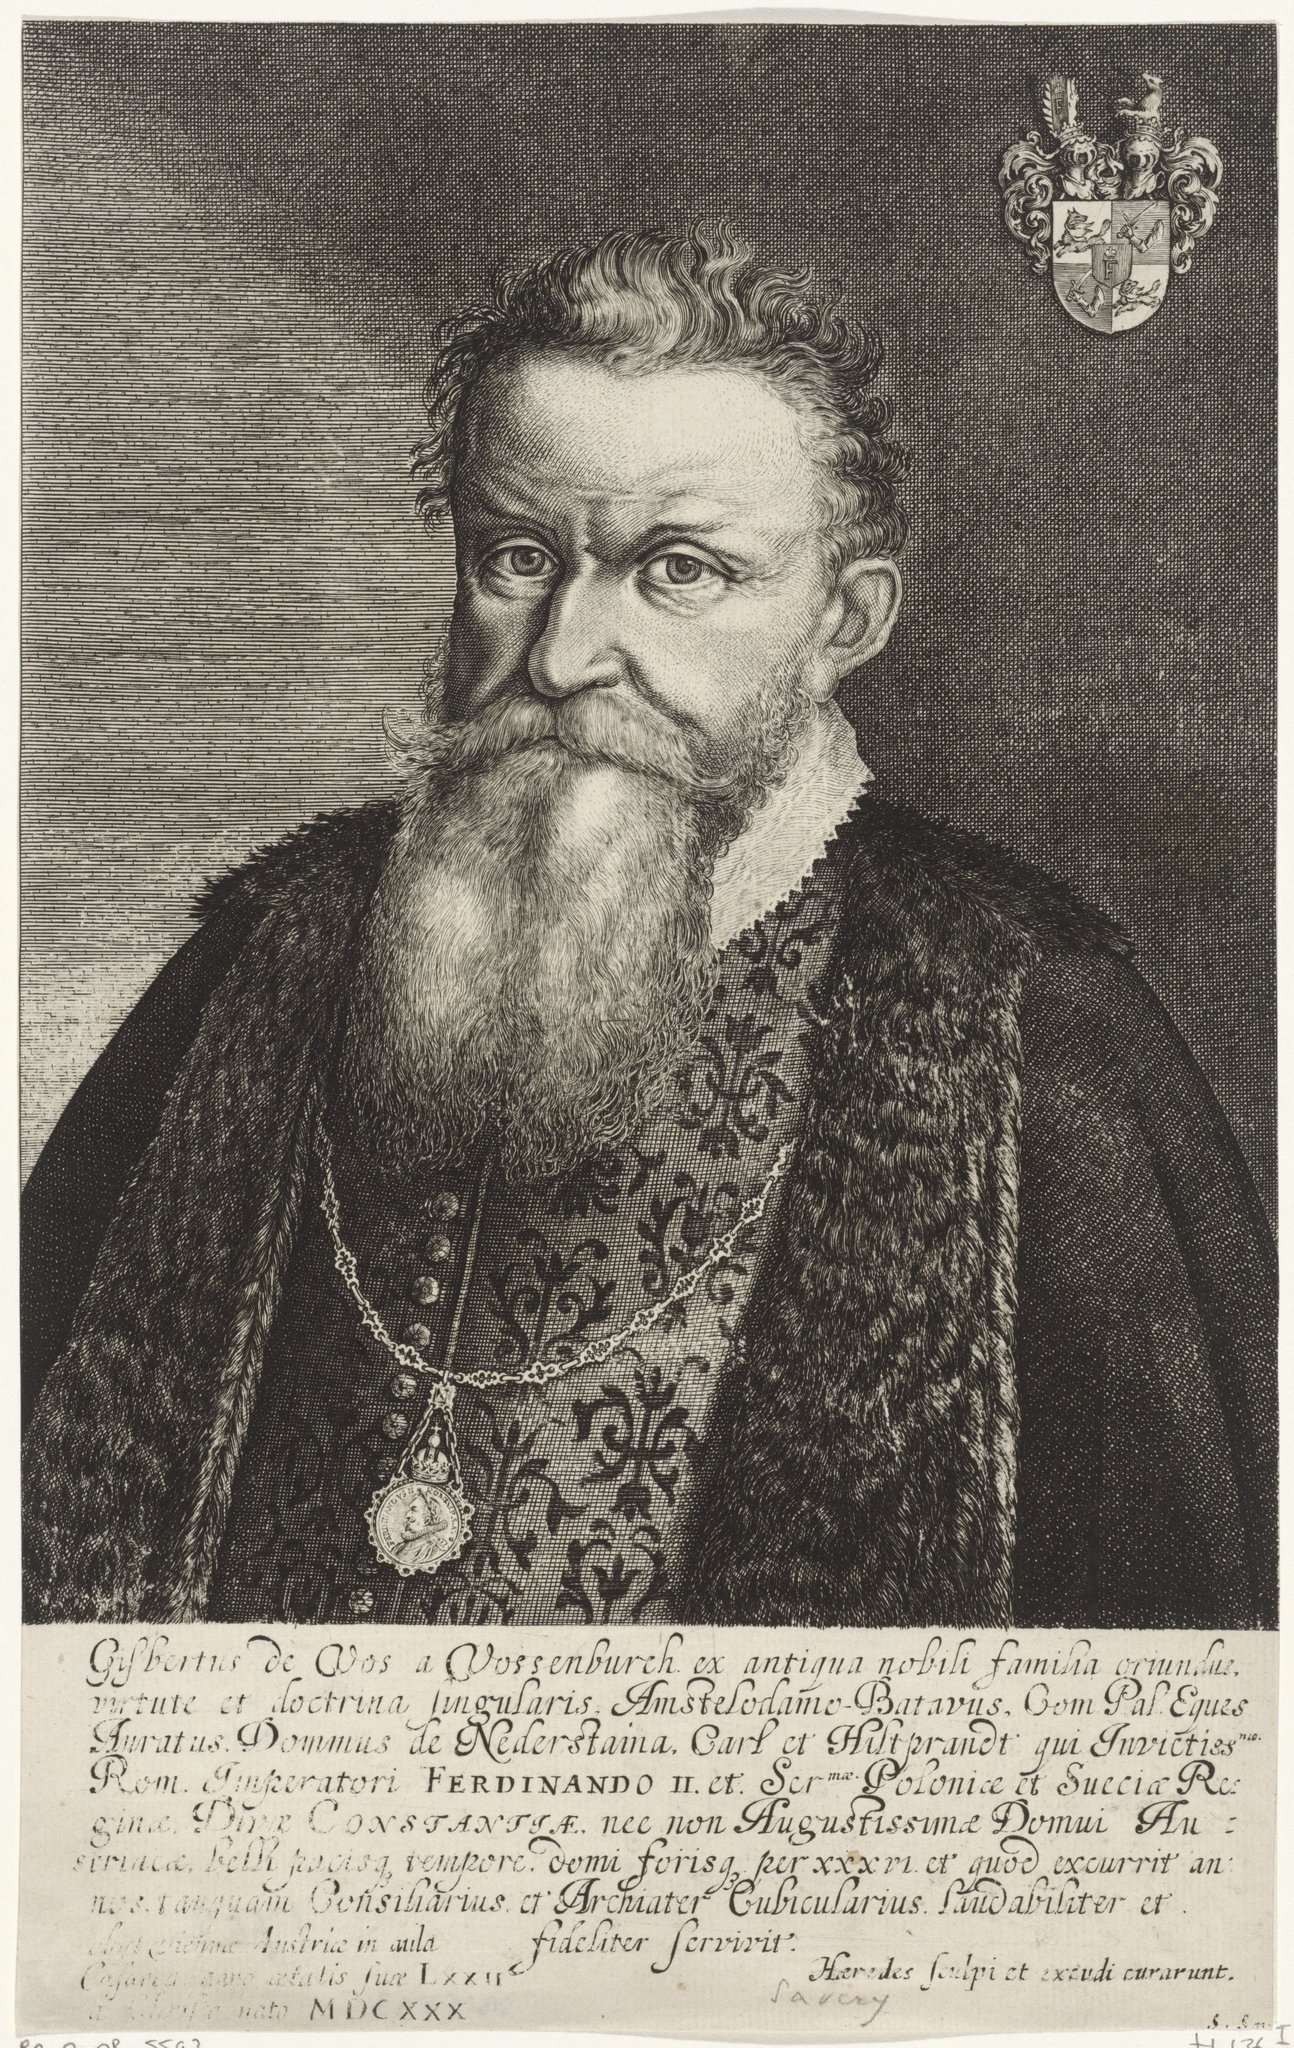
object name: print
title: Portret van Gijsbertus de Vos van Vossenburch, medicus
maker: salomon savery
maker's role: print maker, publisher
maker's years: 1594-1683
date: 1630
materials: paper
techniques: engraving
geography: amsterdam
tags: armorial bearing, heraldry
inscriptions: collector's mark: Lugt 2228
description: Het portret is in opdracht van de erven van Gijsbertus de Vos van Vossenburch gegraveerd en tevens in hun beheer uitgegeven, zie opschrift.